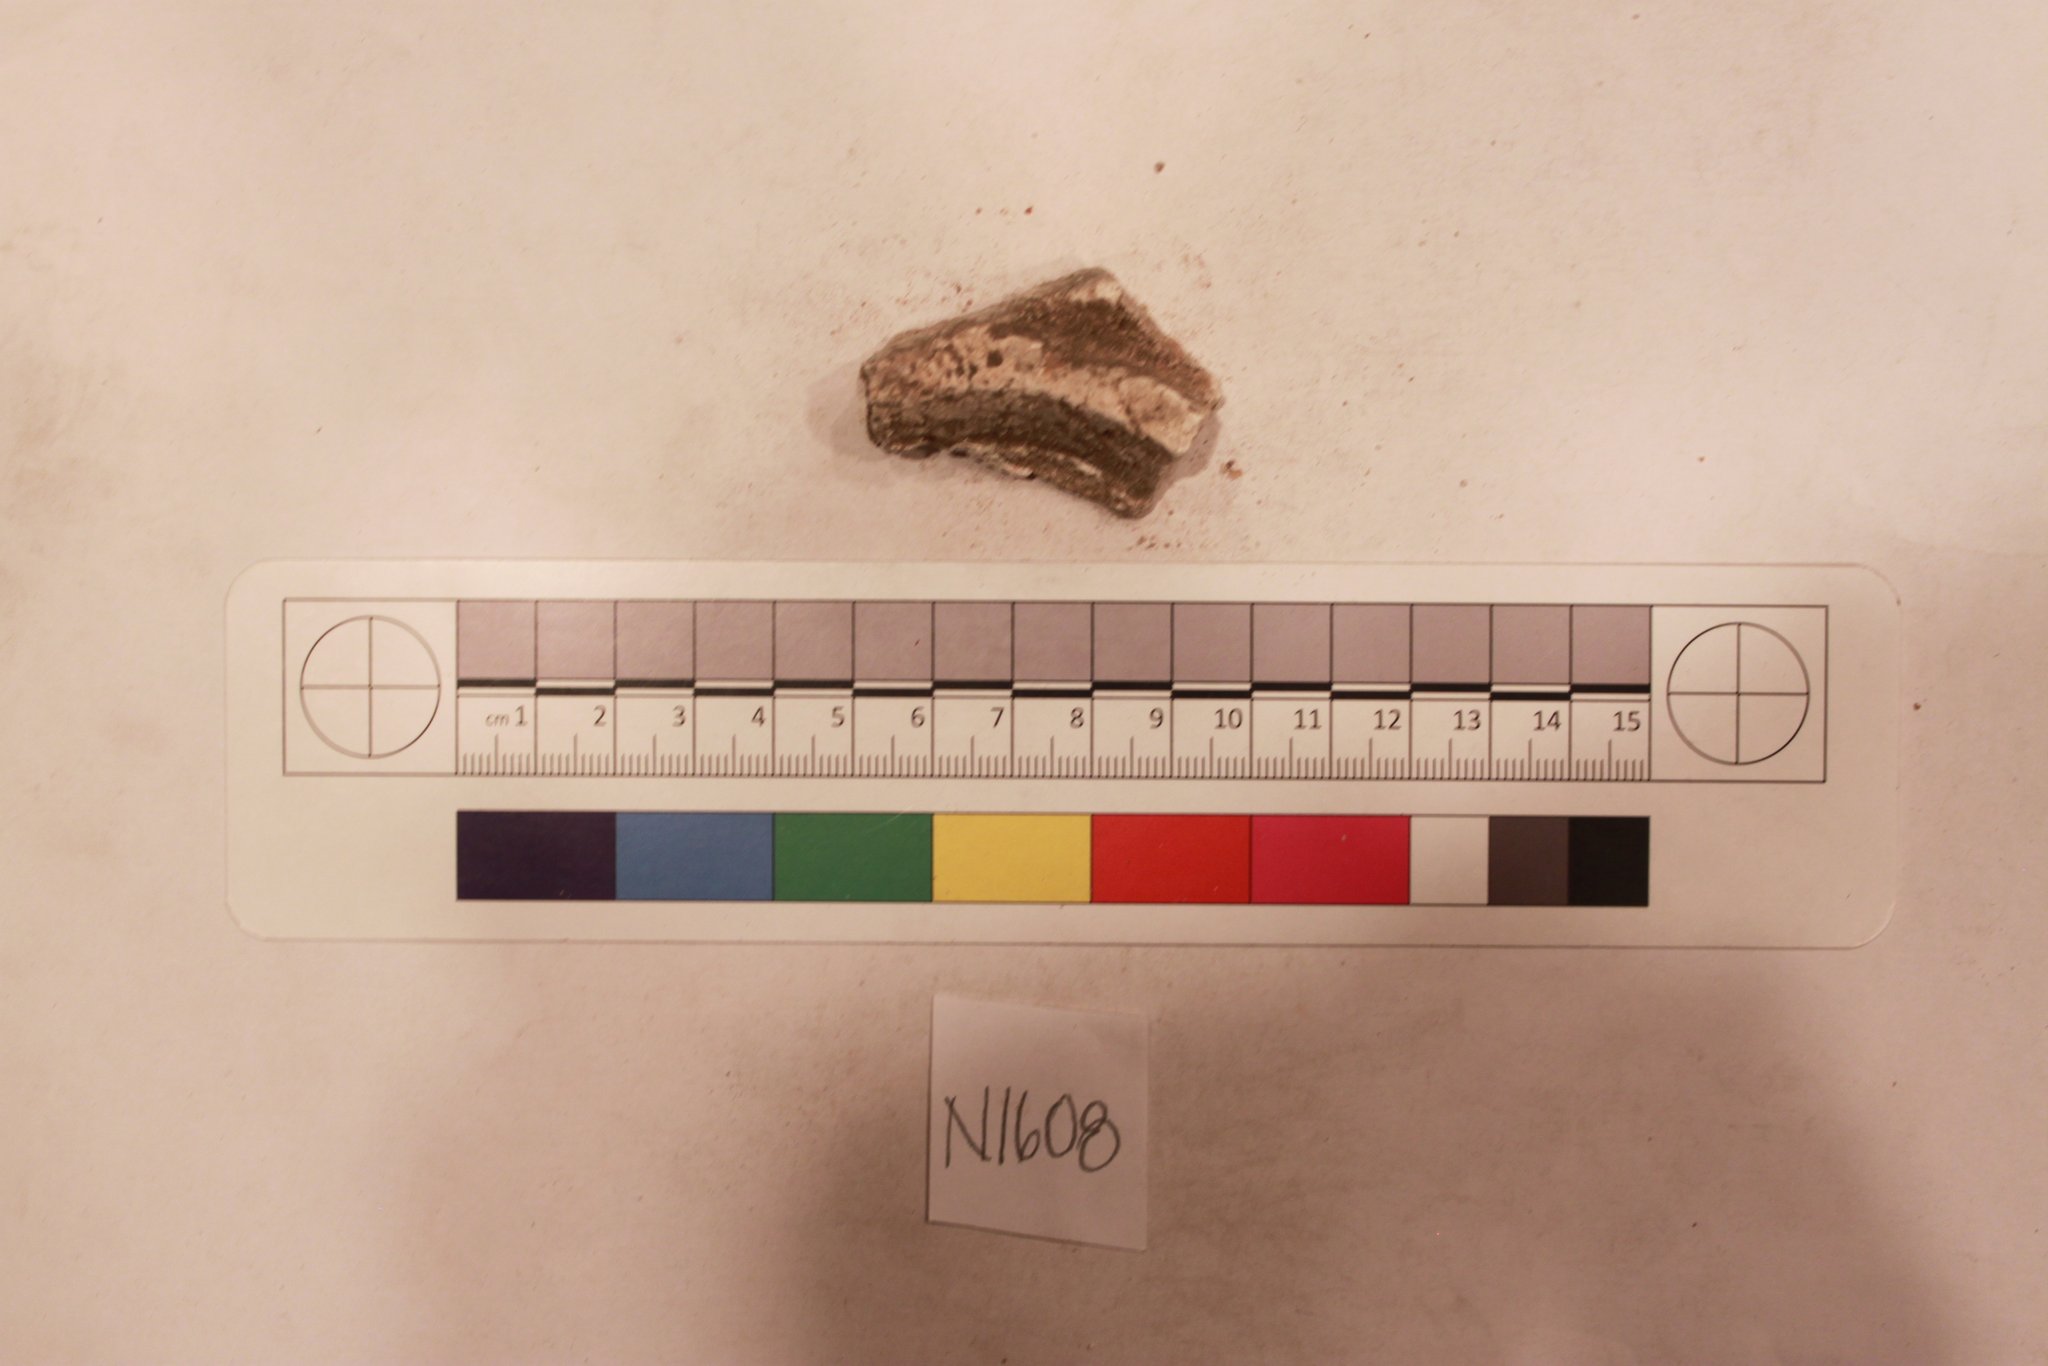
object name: fragment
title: Stucco Fragment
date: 701-1200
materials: plaster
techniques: carving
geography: iran